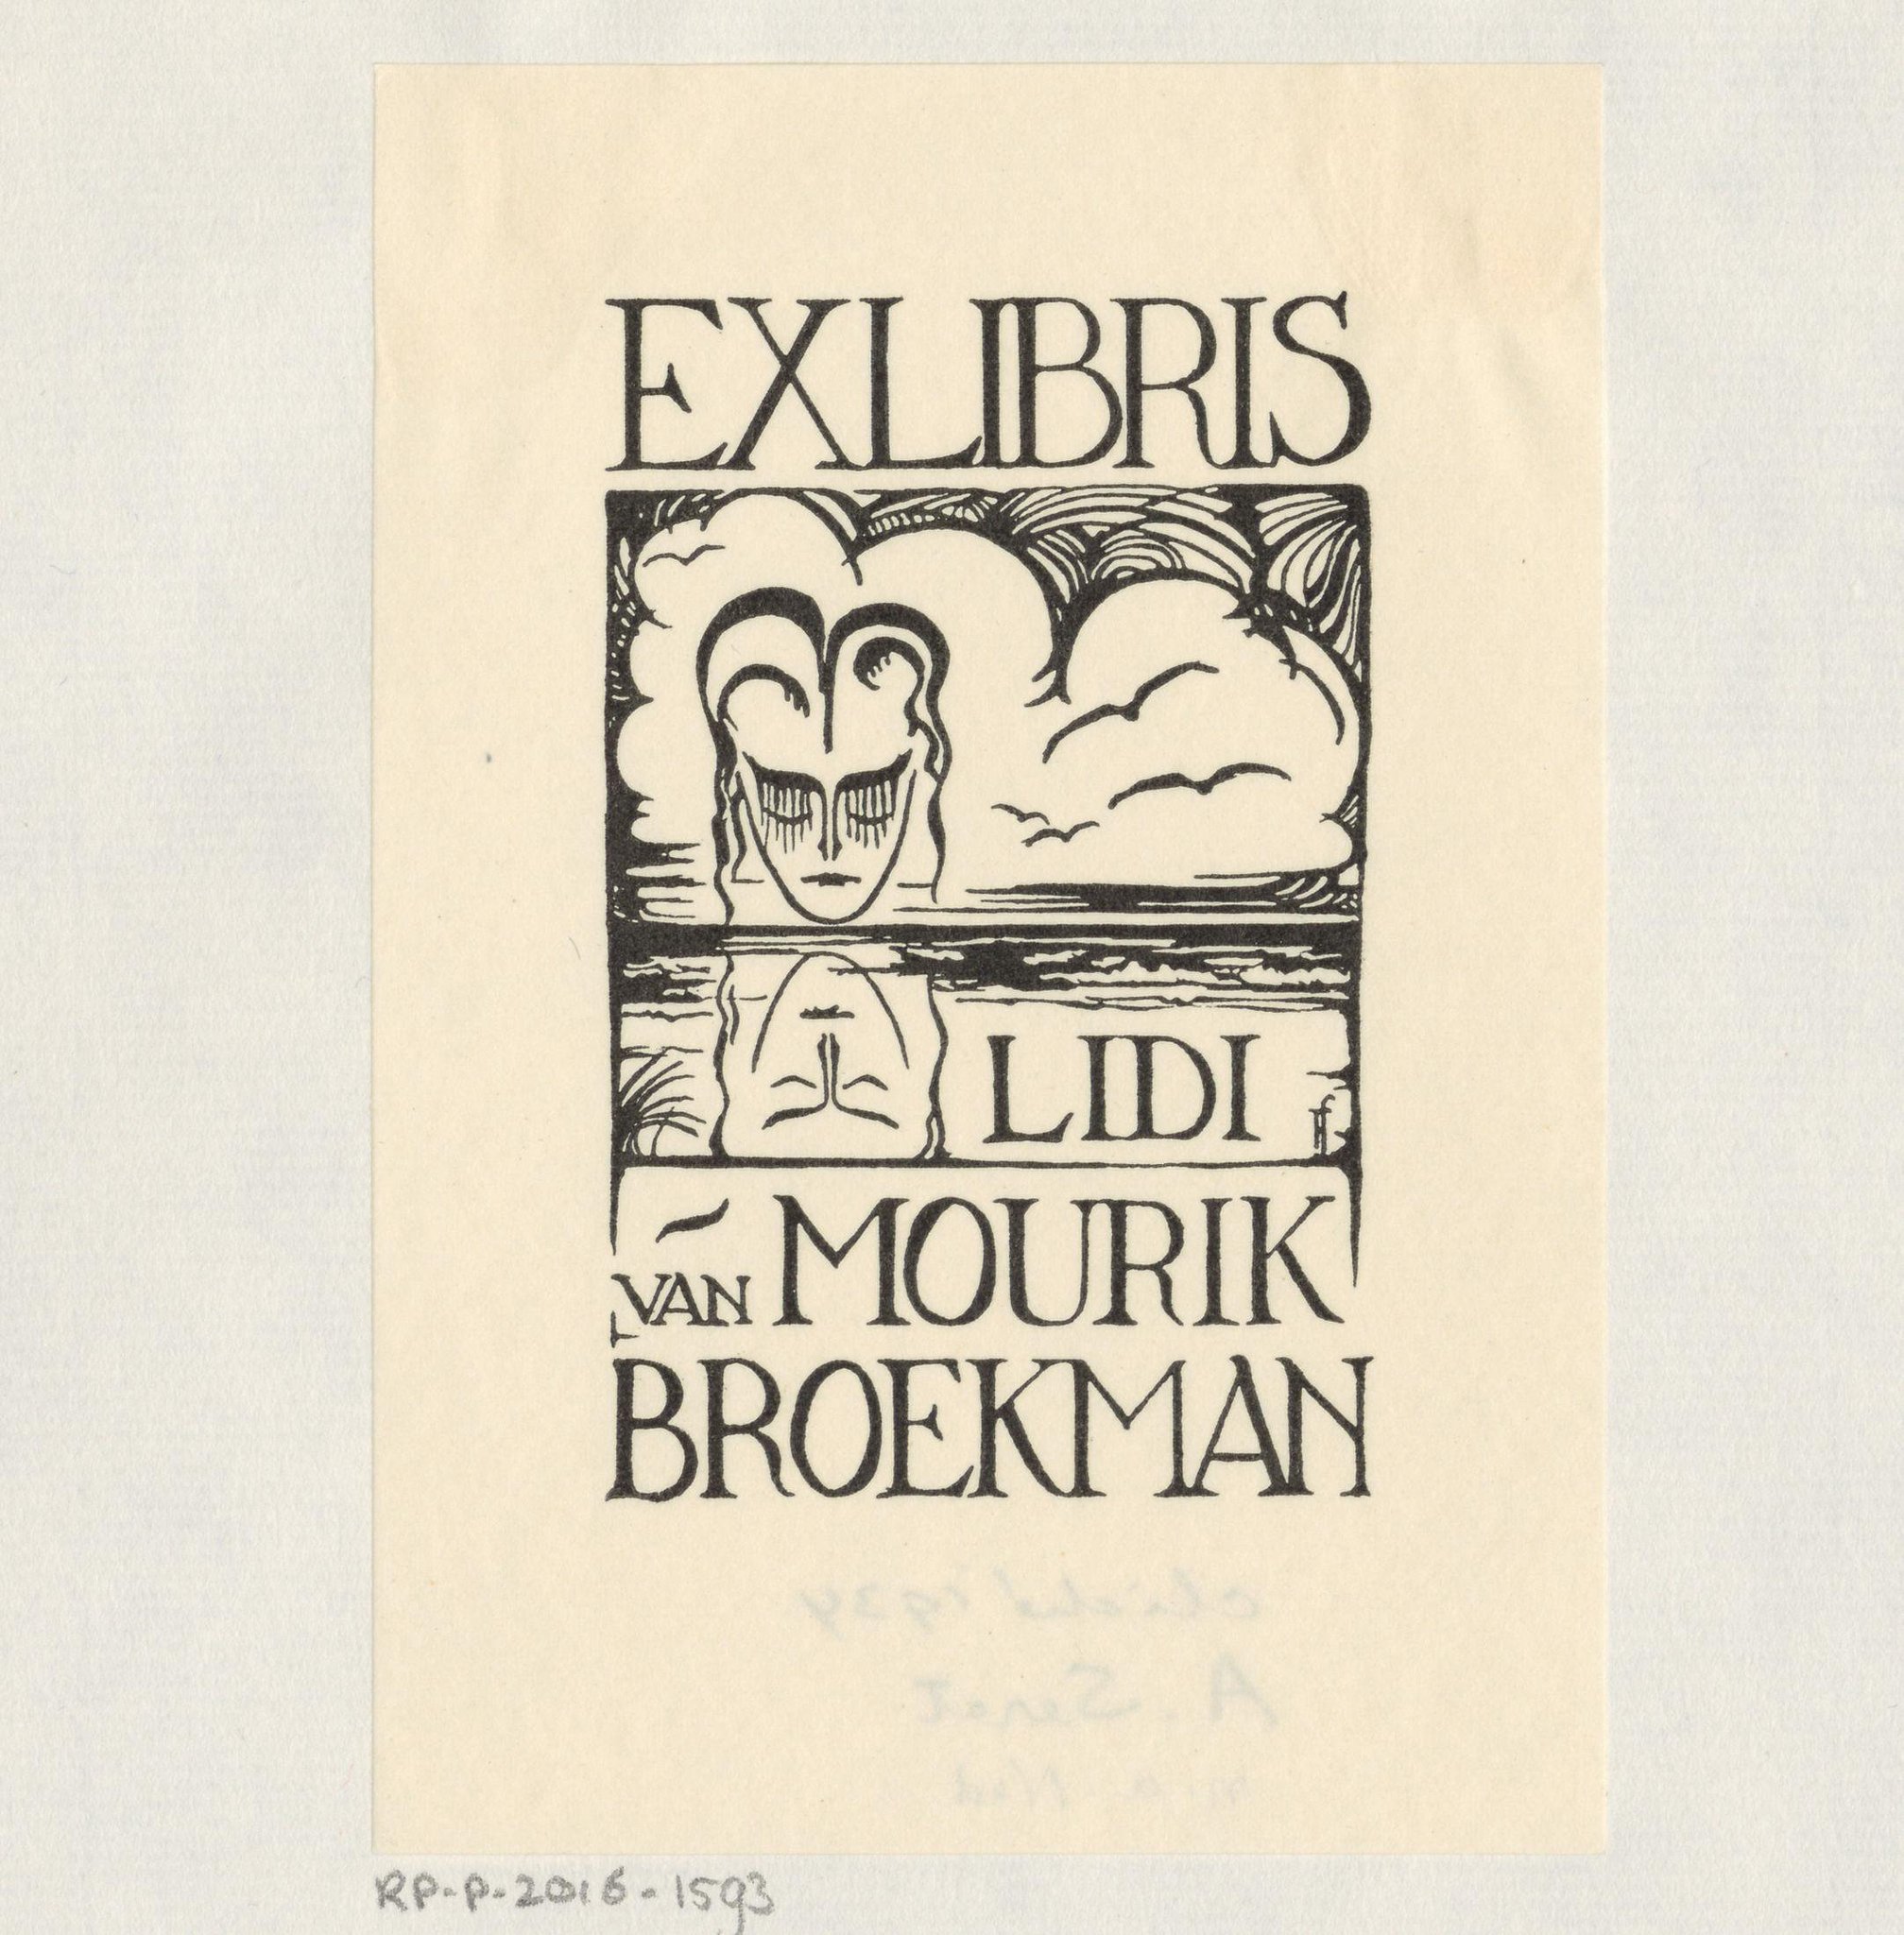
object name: bookplate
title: Ex libris van Lidi van Mourik Broekman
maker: a. seret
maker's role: print maker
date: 1932-1934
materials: paper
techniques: printing block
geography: netherlands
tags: painter, sculptor, lidi van mourik broekman, mask, surf, breakers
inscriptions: inscription: ‘cliché 1945 / A. Seret’